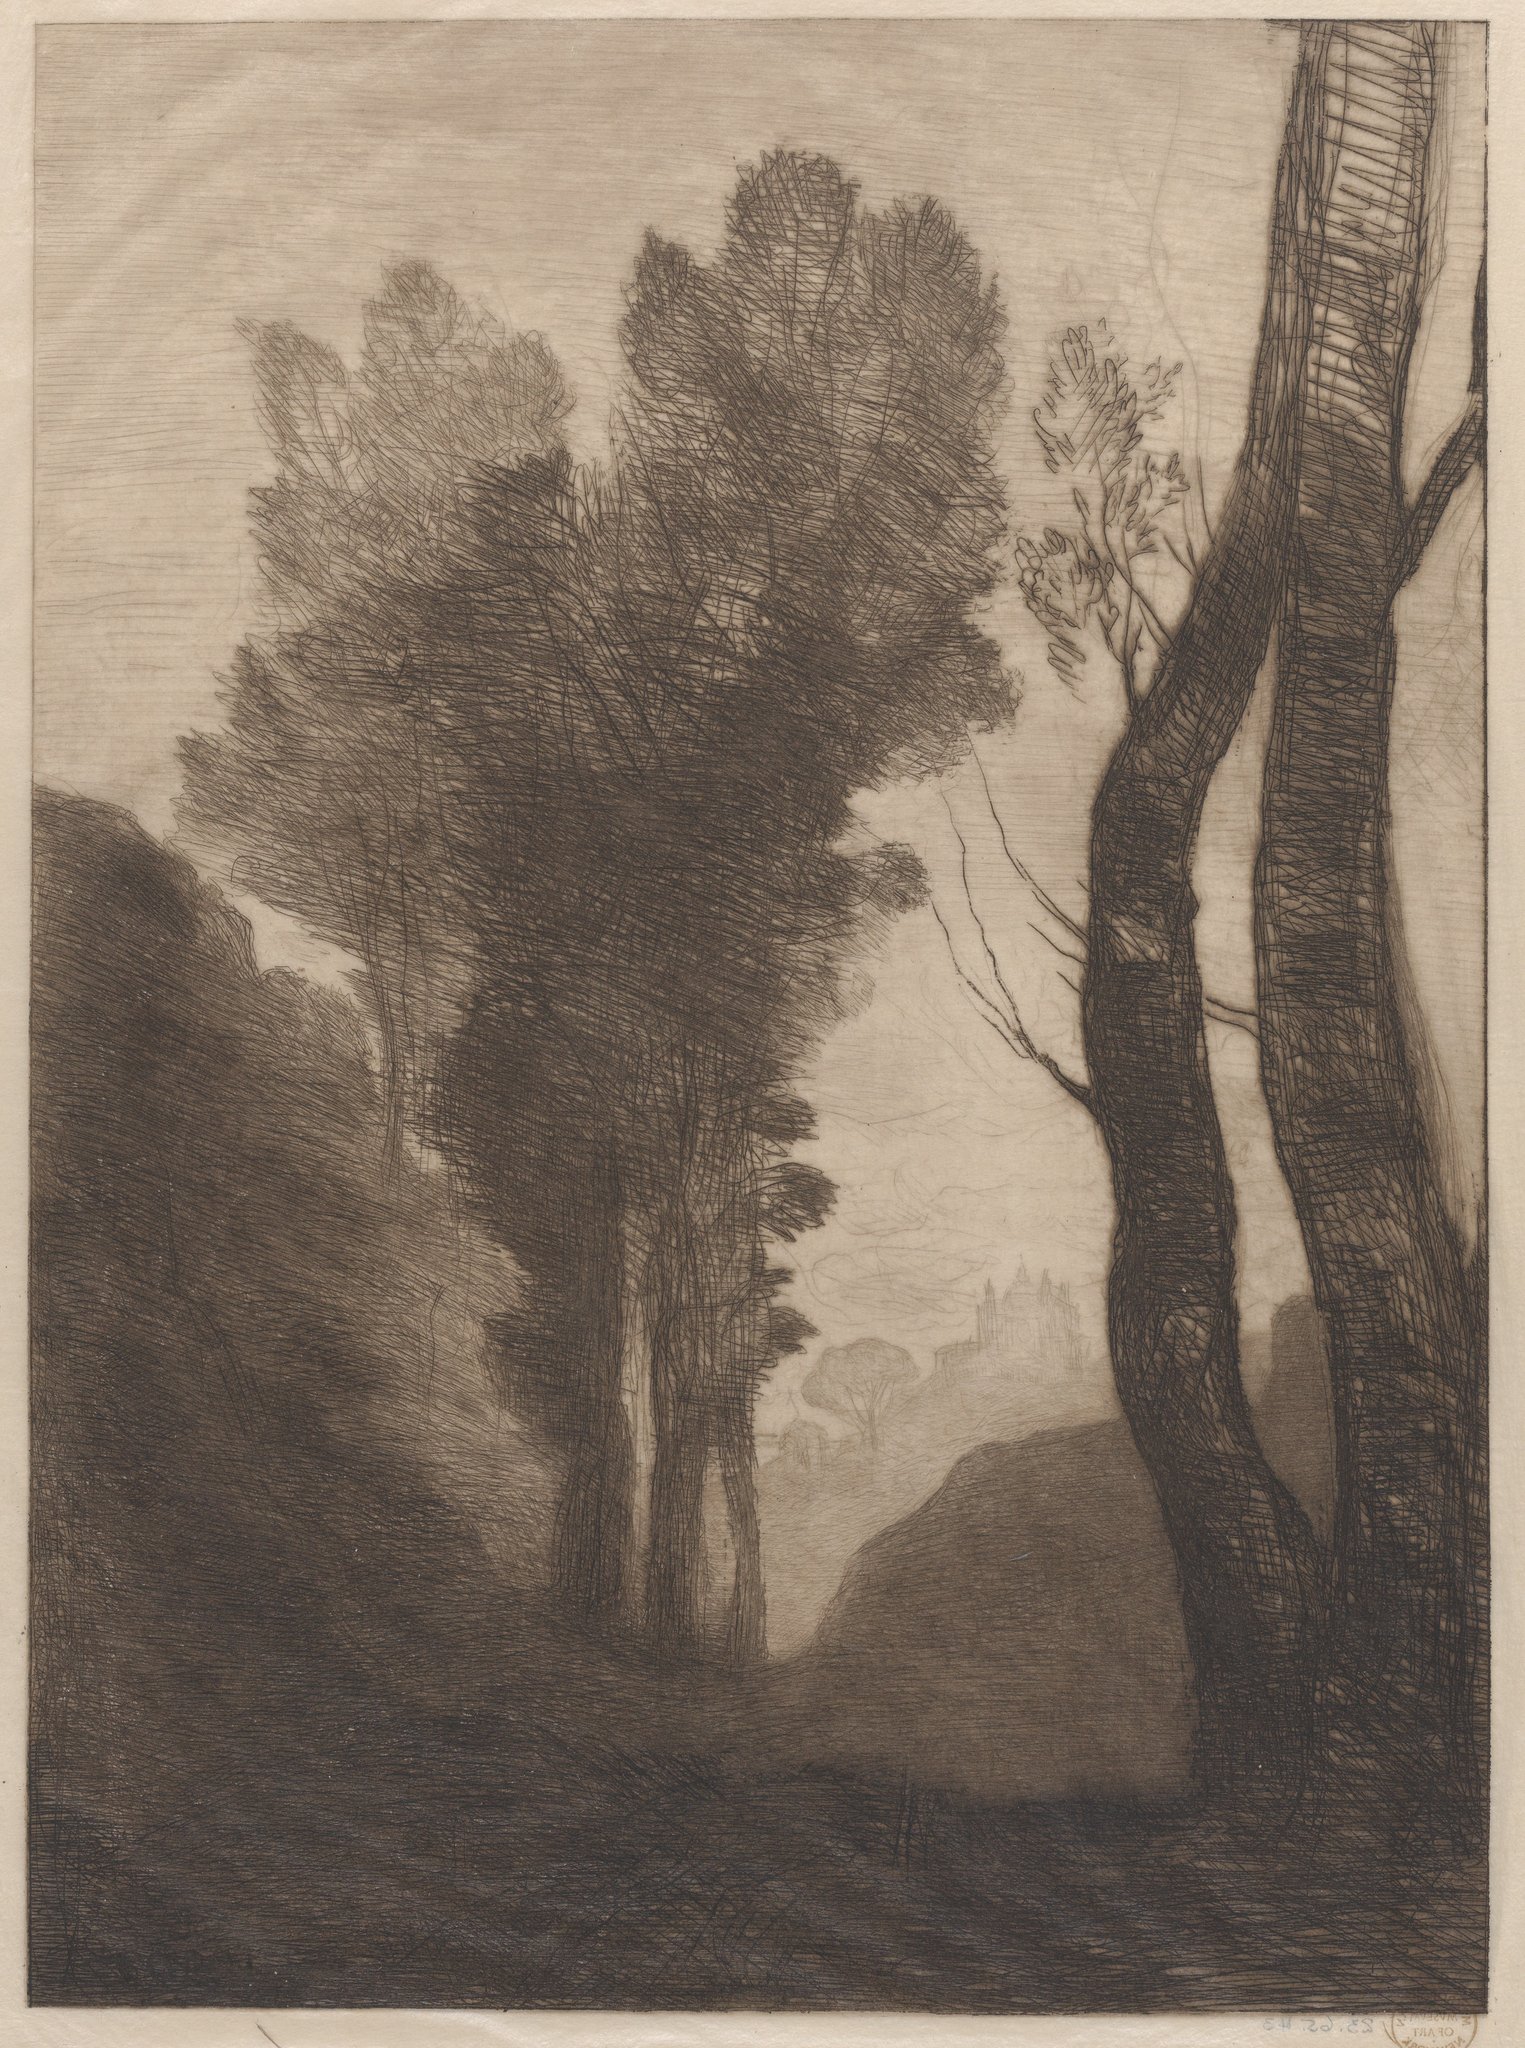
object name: print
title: Environs of Rome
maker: jean-baptiste-camille corot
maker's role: artist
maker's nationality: french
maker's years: 1796-1875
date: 1866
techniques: etching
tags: landscapes,trees